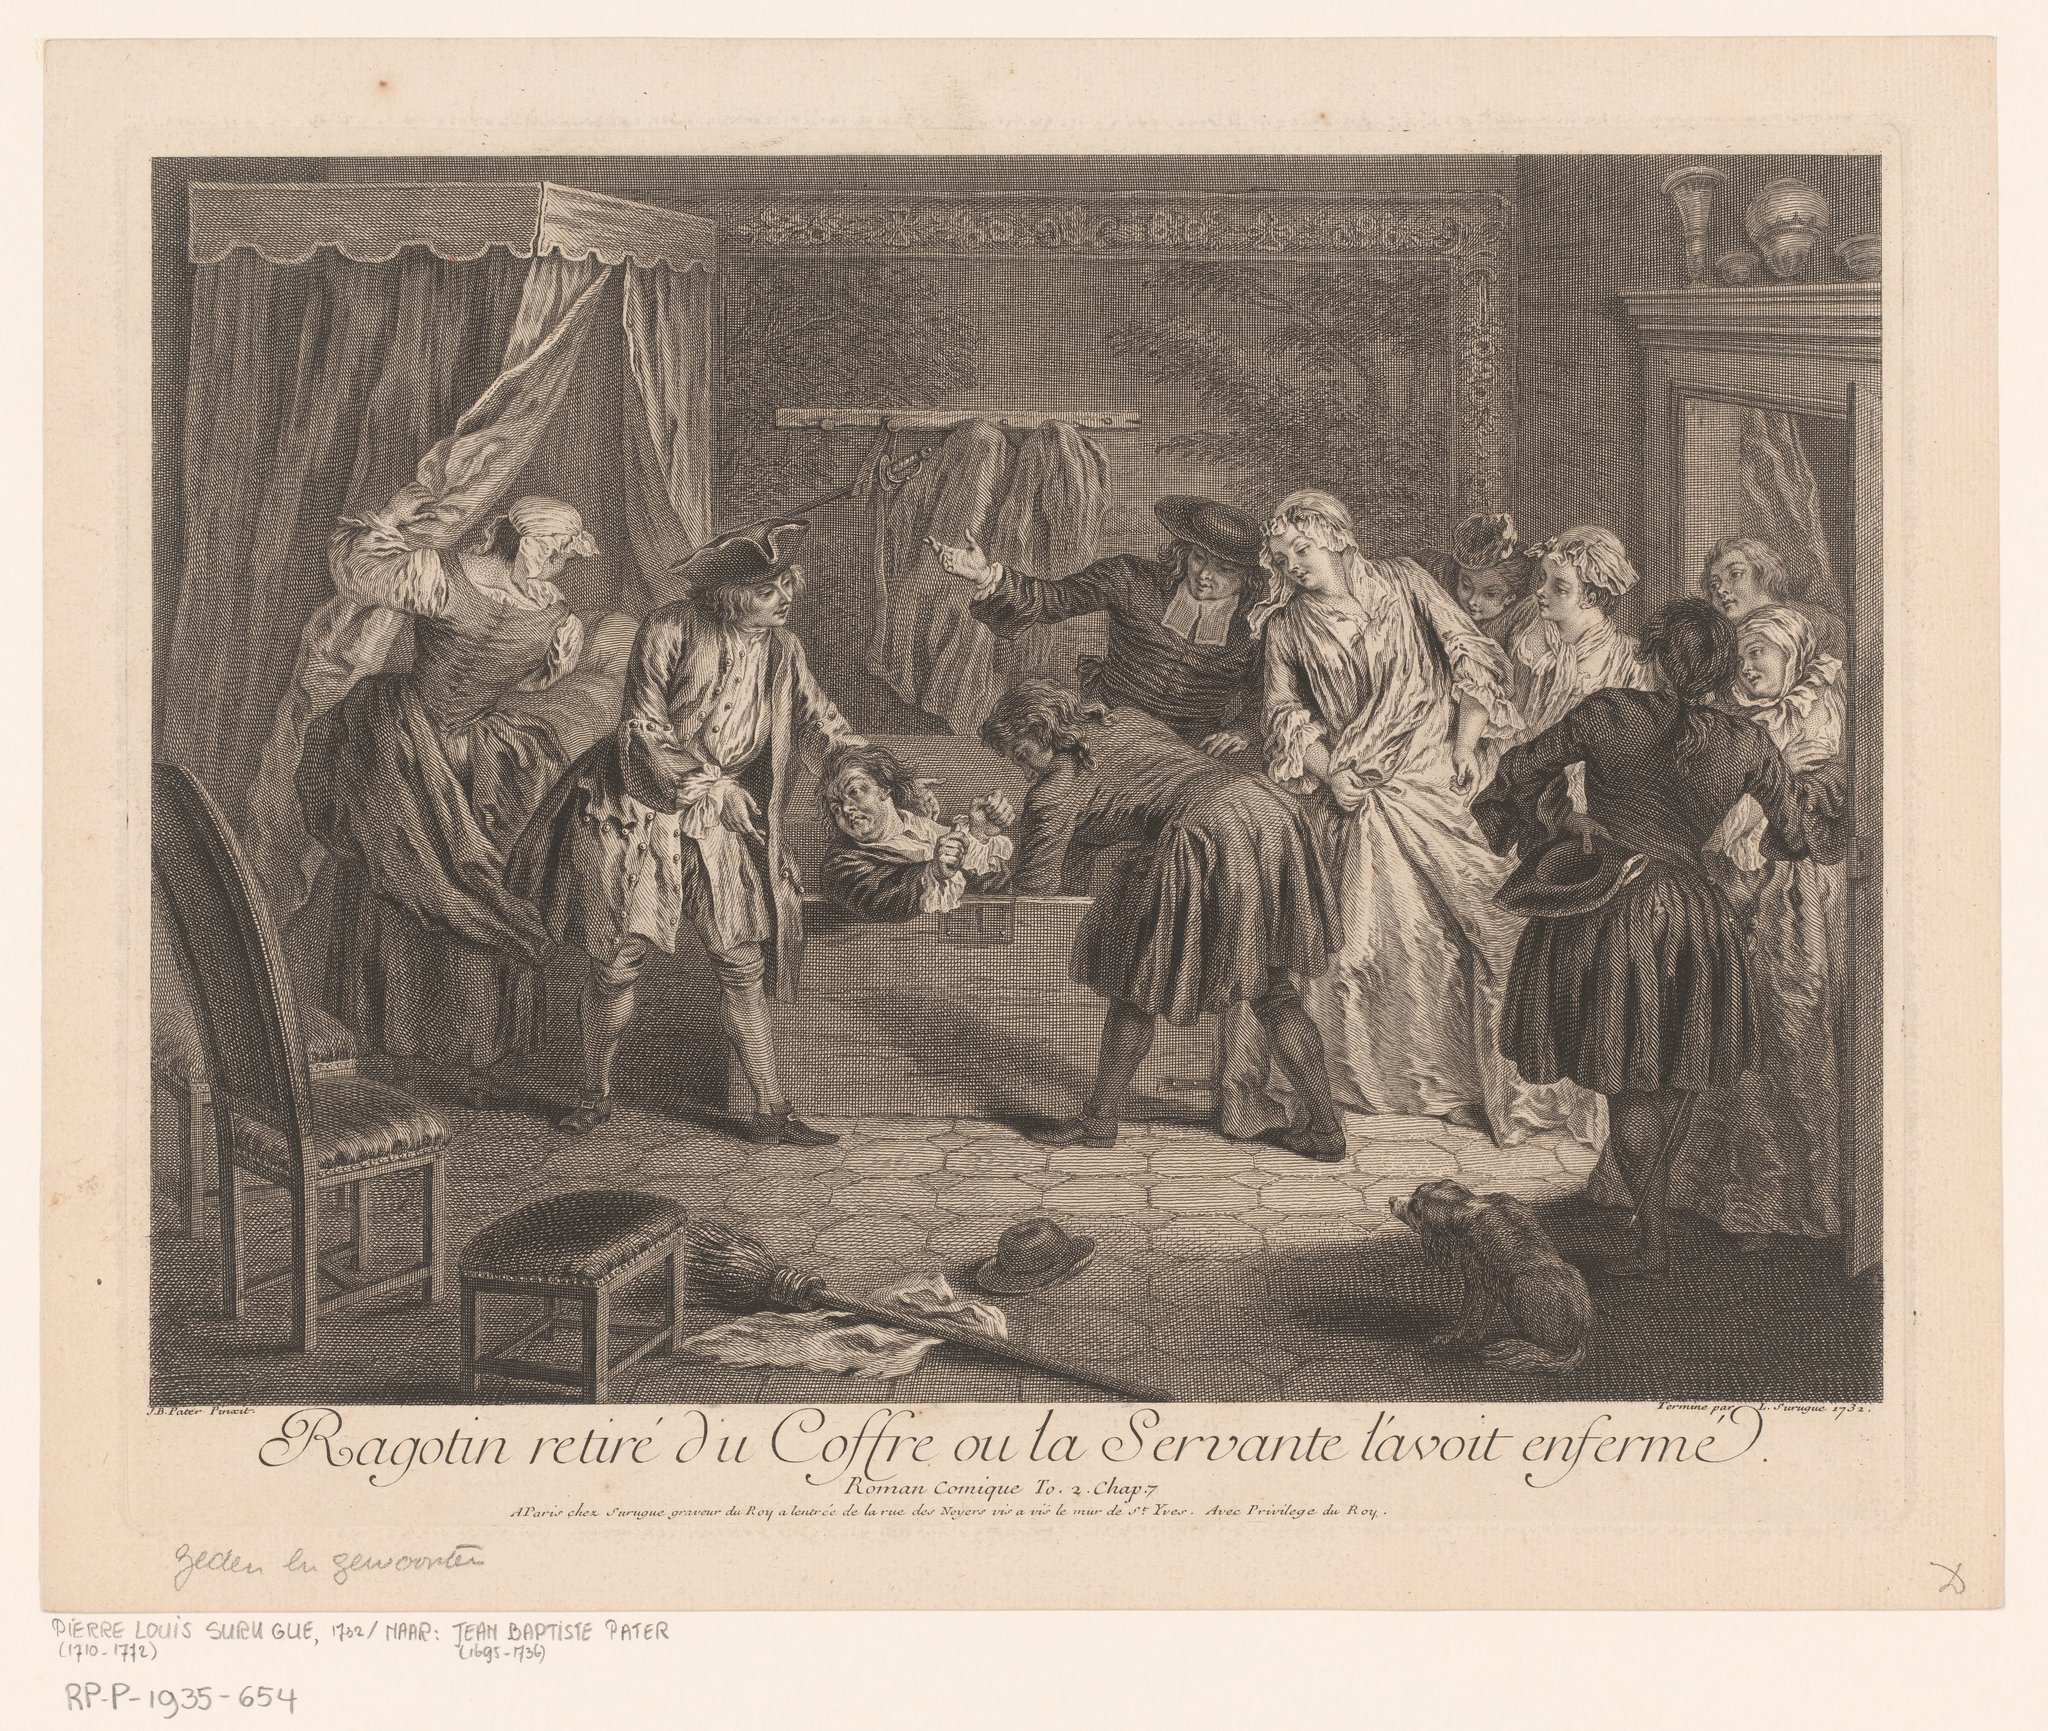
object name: print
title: Slaapkamerinterieur met gezelschap en Ragotin in een kist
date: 1732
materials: paper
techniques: engraving, etching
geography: paris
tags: (scarron, roman comique) specific works of literature (with author, title), chest, coffer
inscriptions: collector's mark: Lugt 2228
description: Serie van 16 prenten bij de Roman Comique van Scarron, waarvan een aantal door Louis en Pierre Louis Surugue.